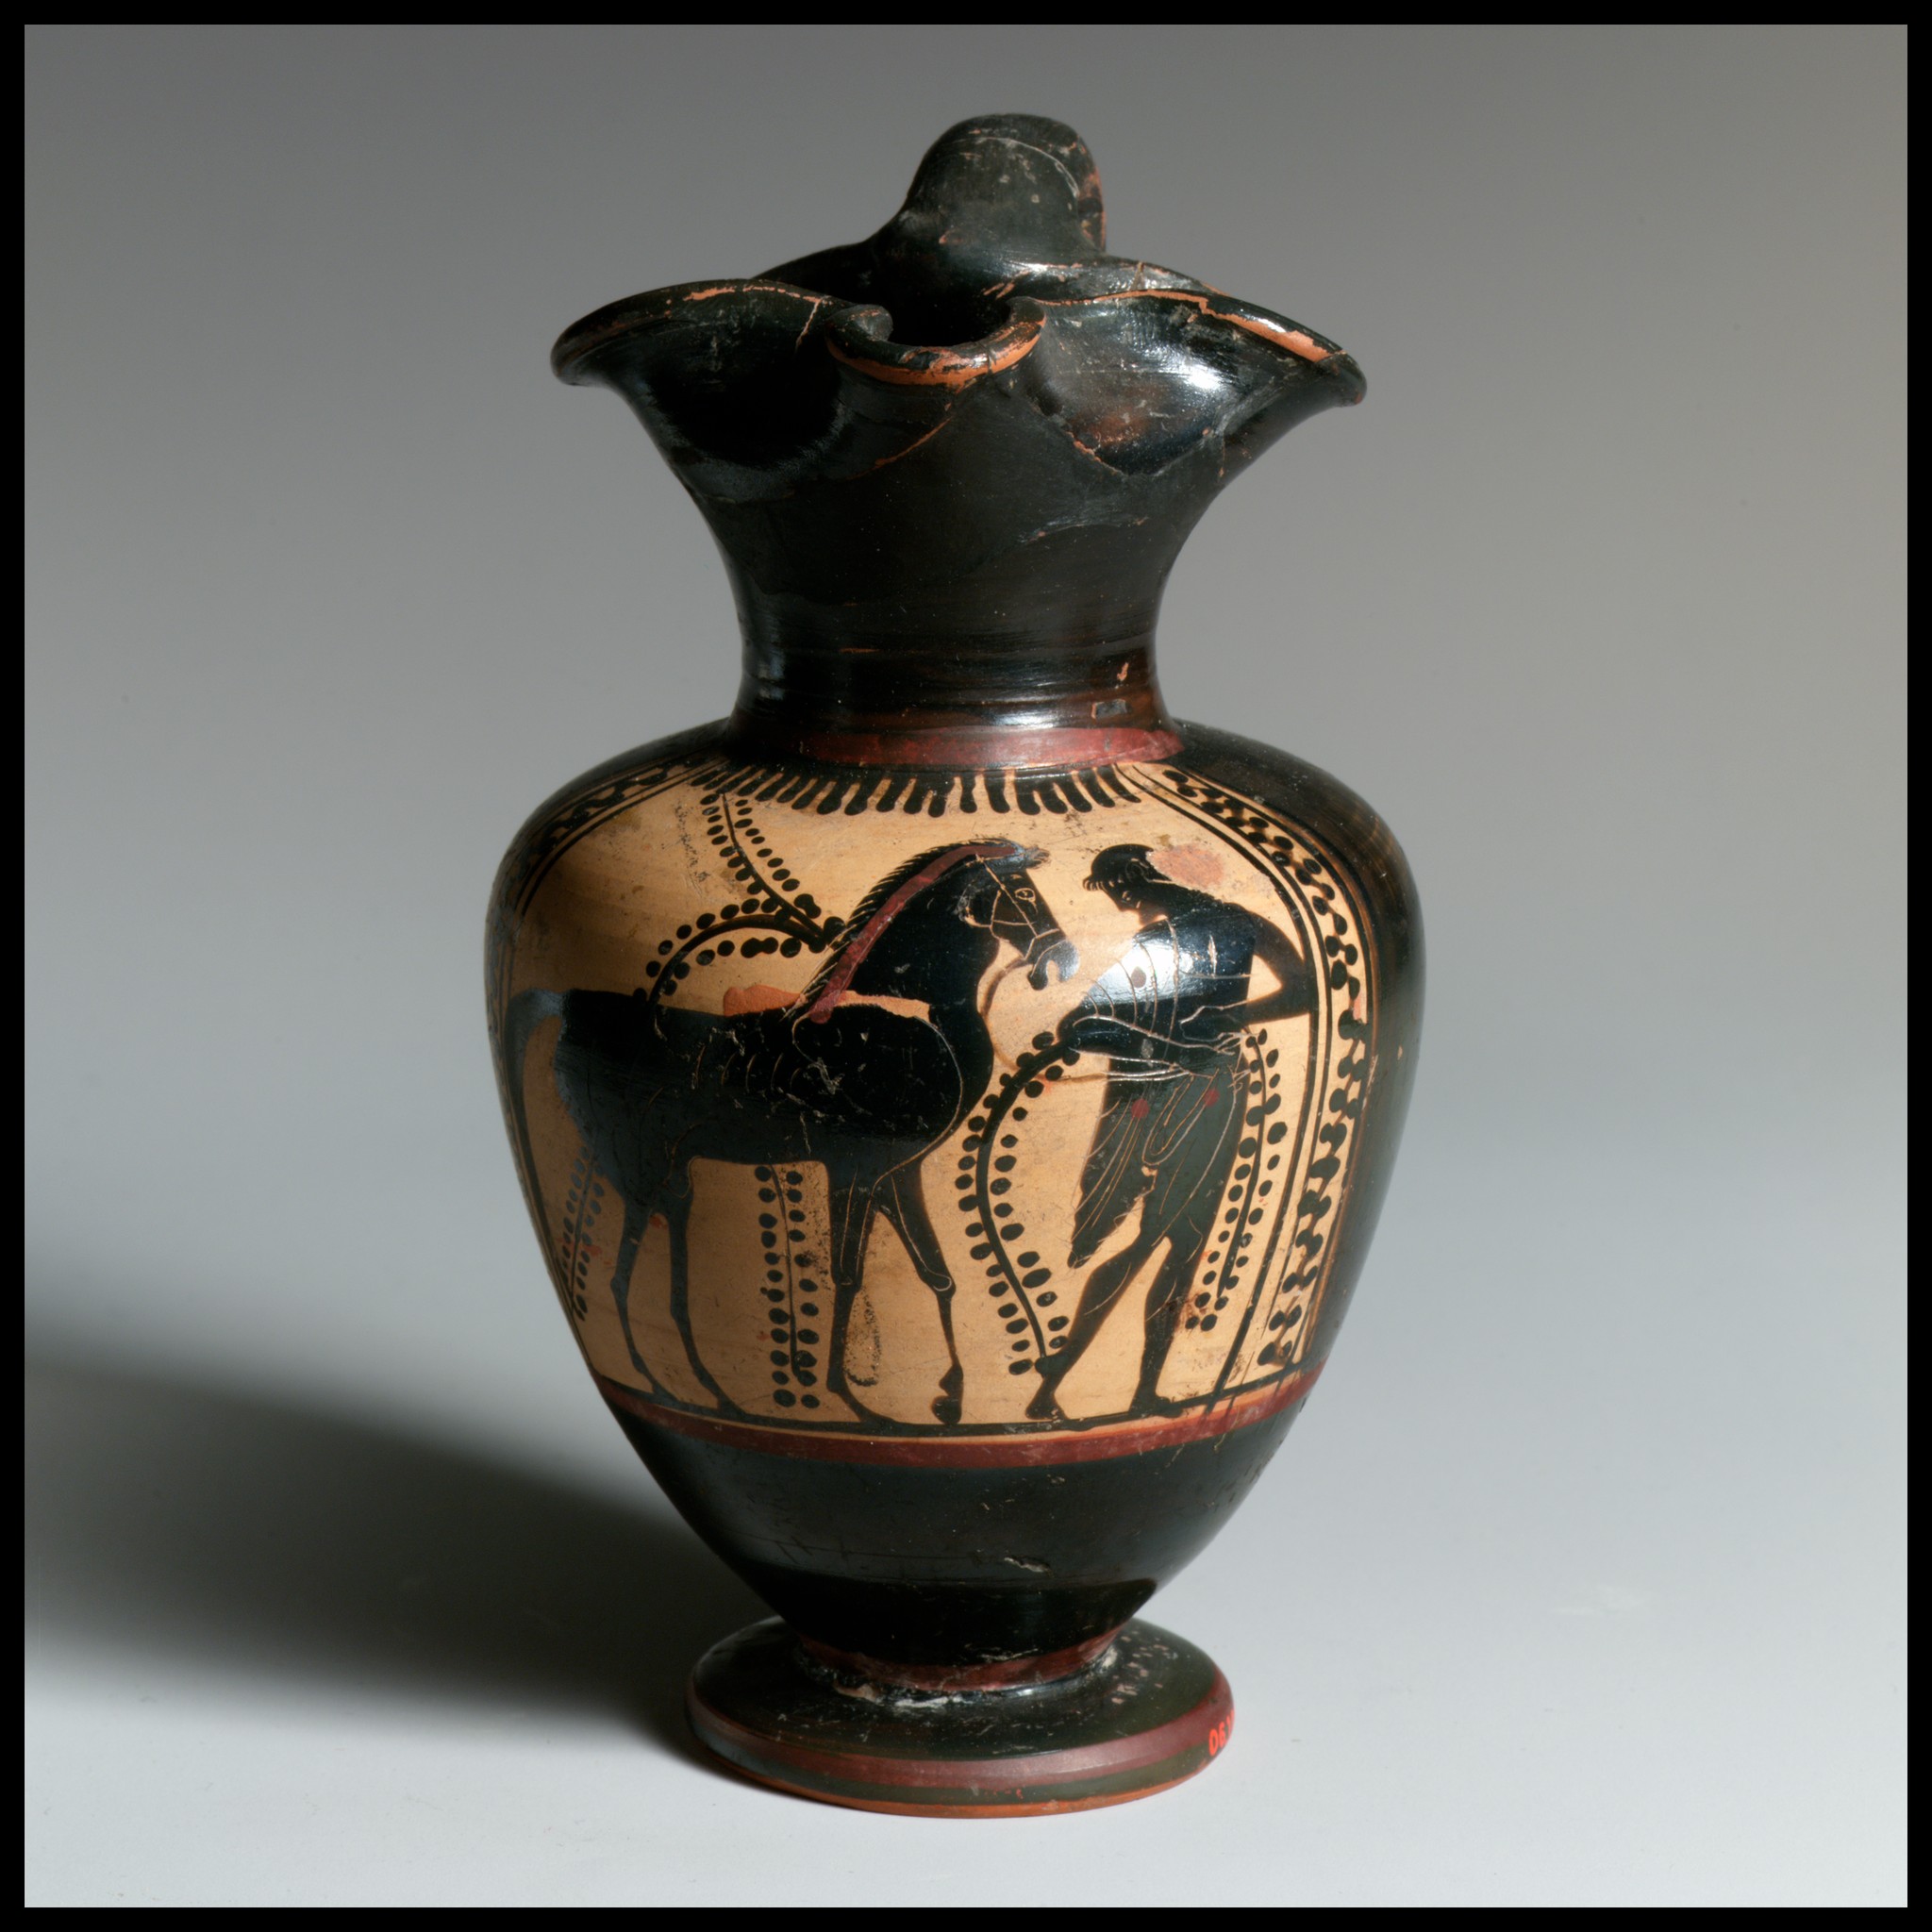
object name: oinochoe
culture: greek, attic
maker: athena painter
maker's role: artist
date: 500-476 BCE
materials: terracotta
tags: men,horses